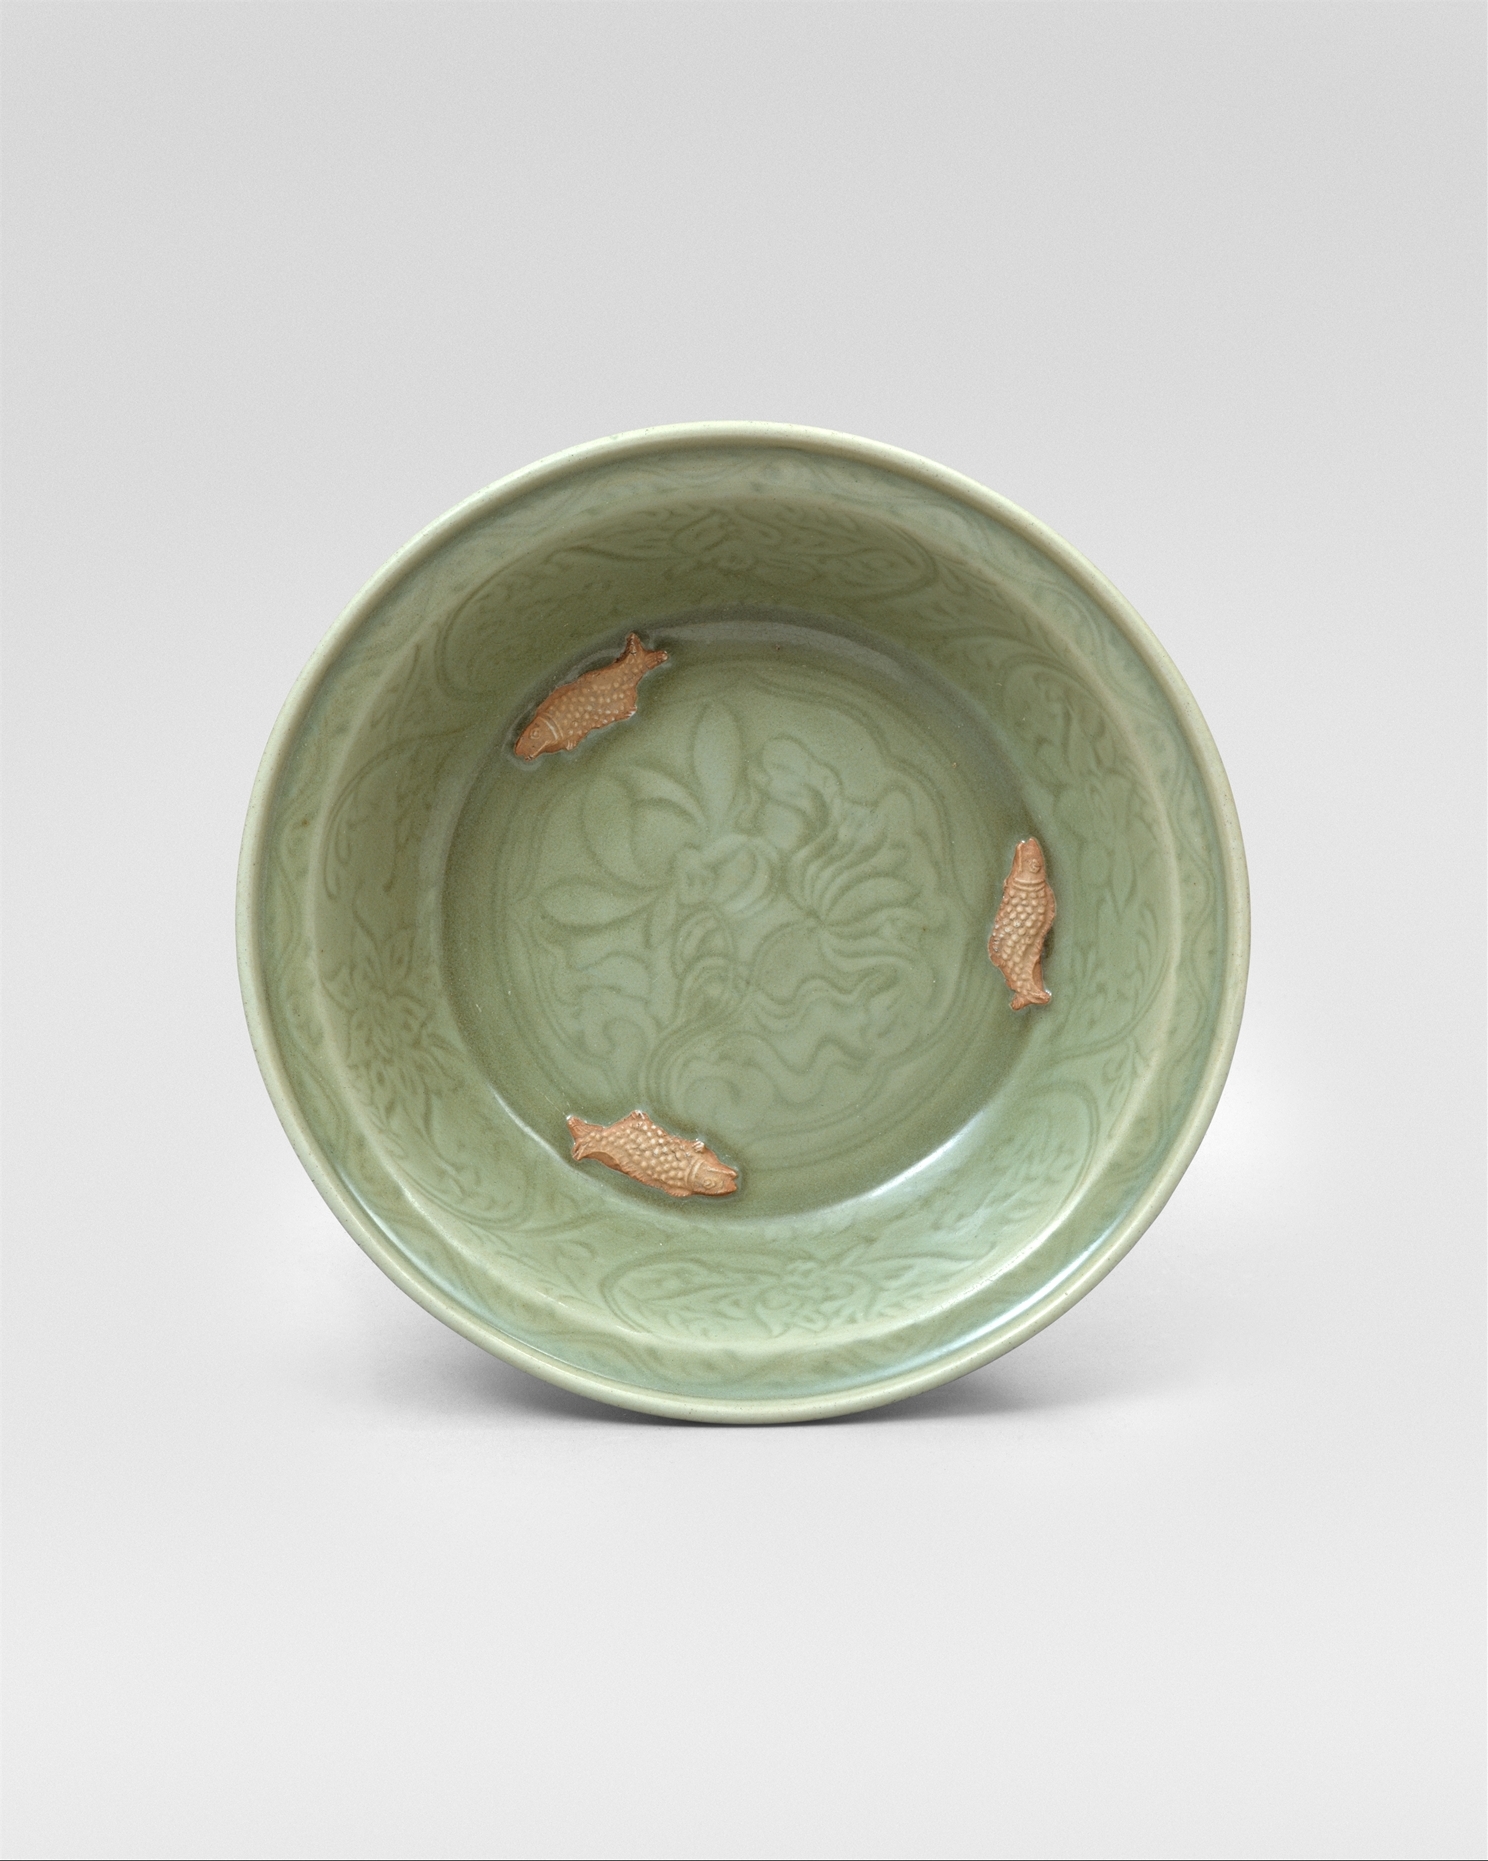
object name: basin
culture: chinese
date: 1367-1433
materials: biscuit, ceramic glaze, glaze, stoneware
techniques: incising, relief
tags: fish